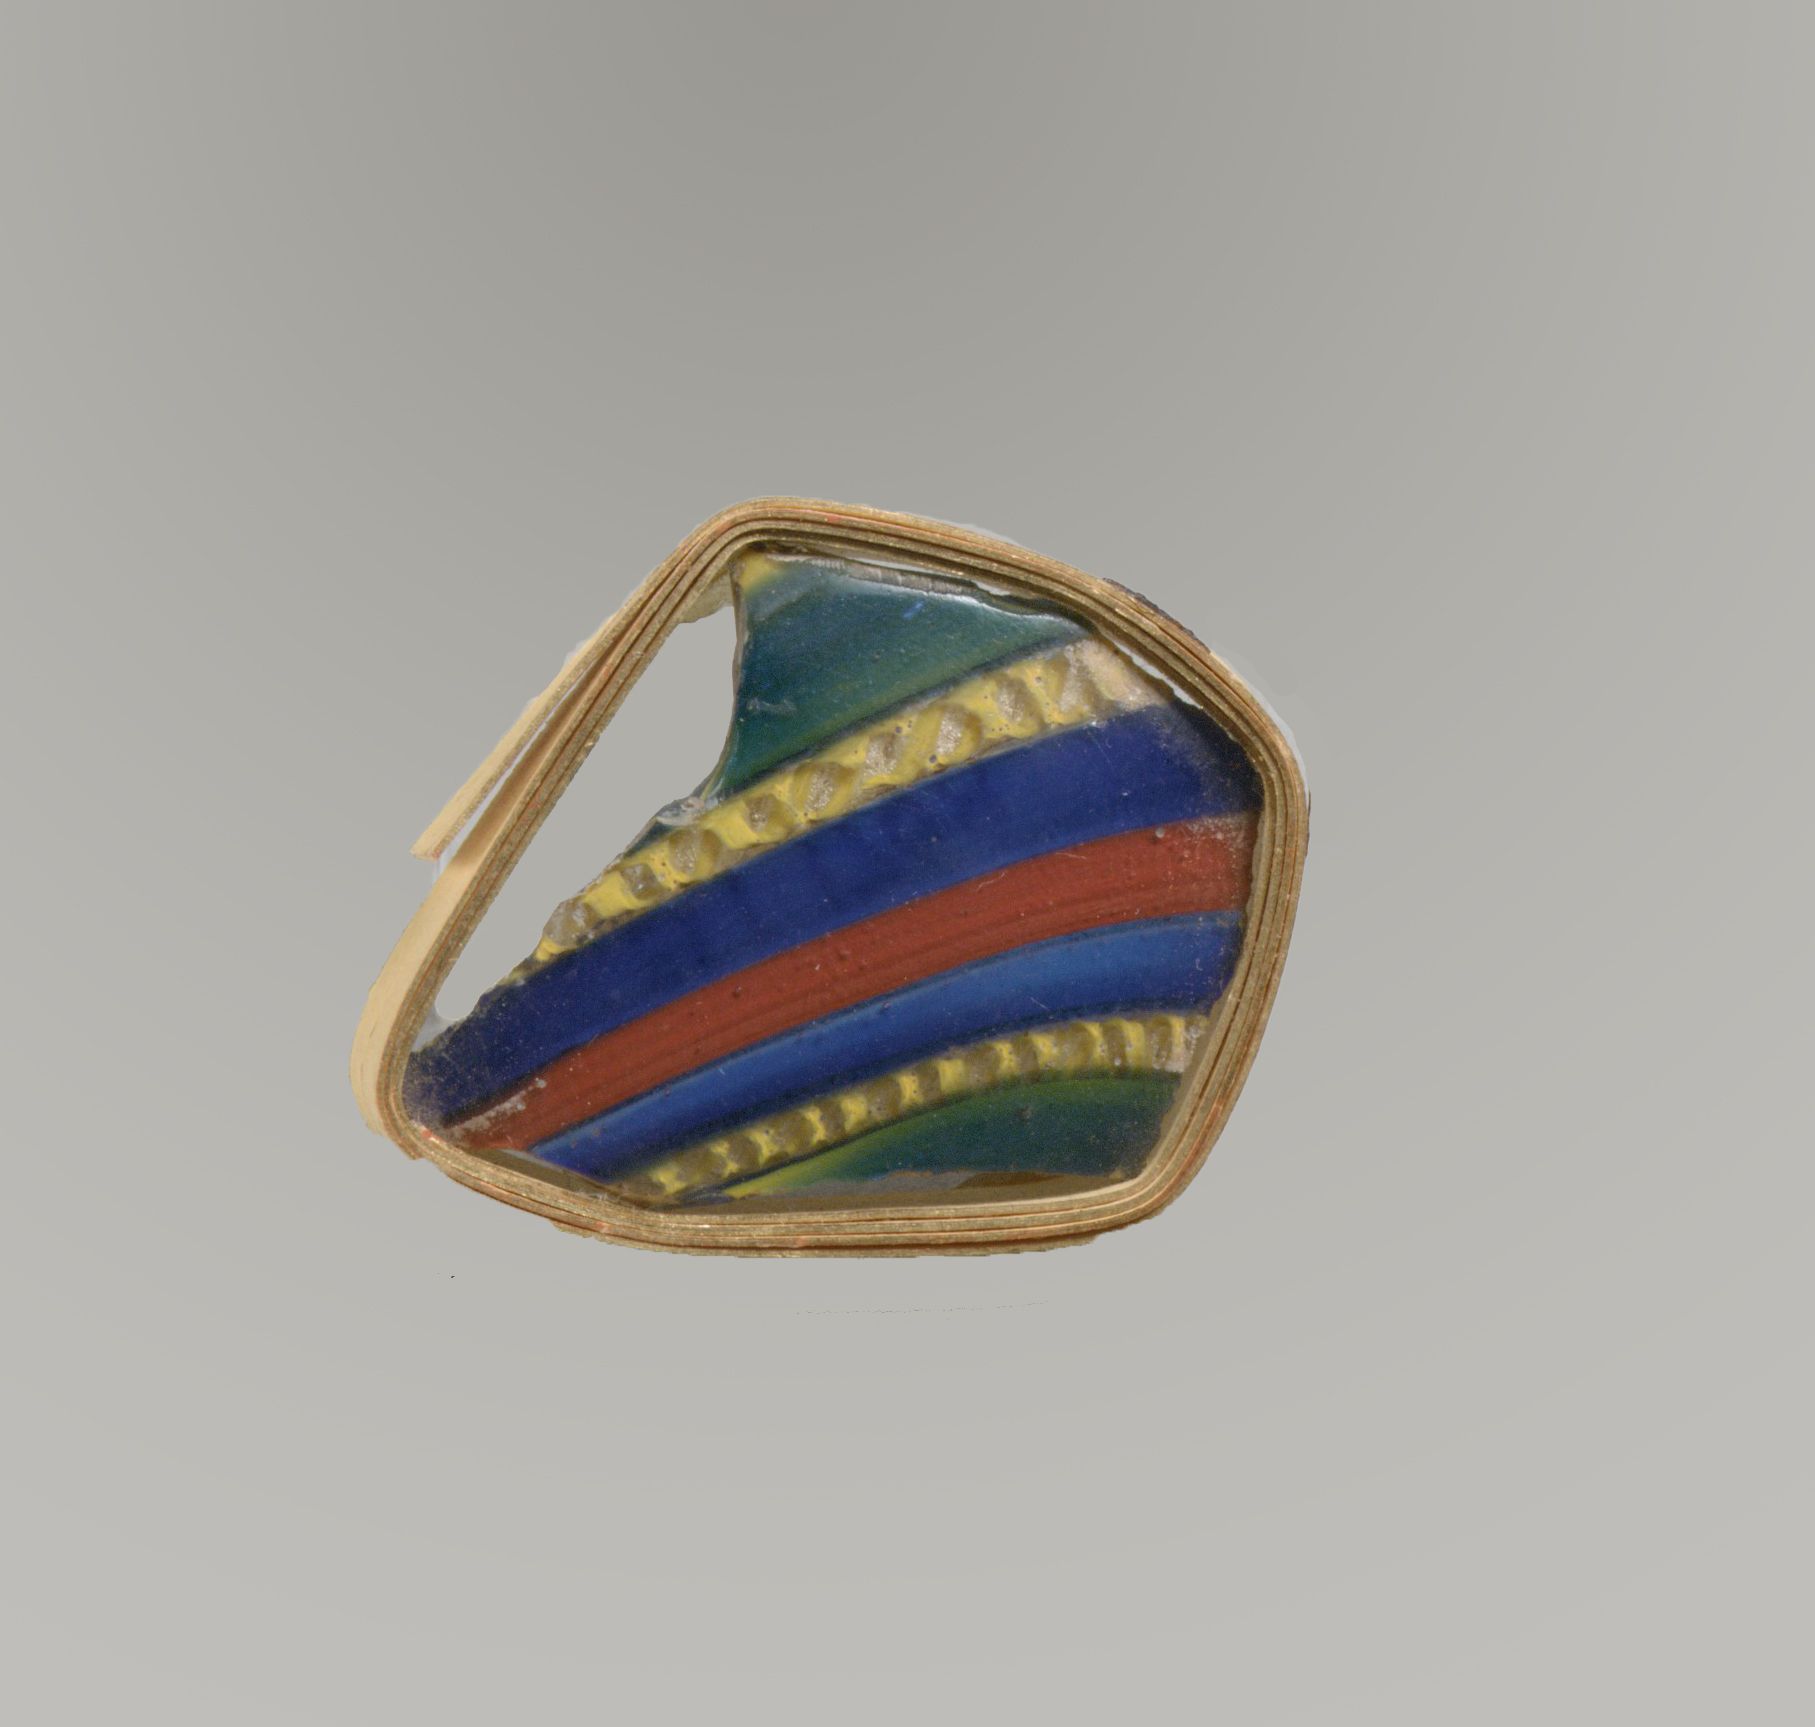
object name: fragment, striped mosaic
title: Glass striped mosaic bowl fragment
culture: roman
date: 34 BCE-33 CE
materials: glass